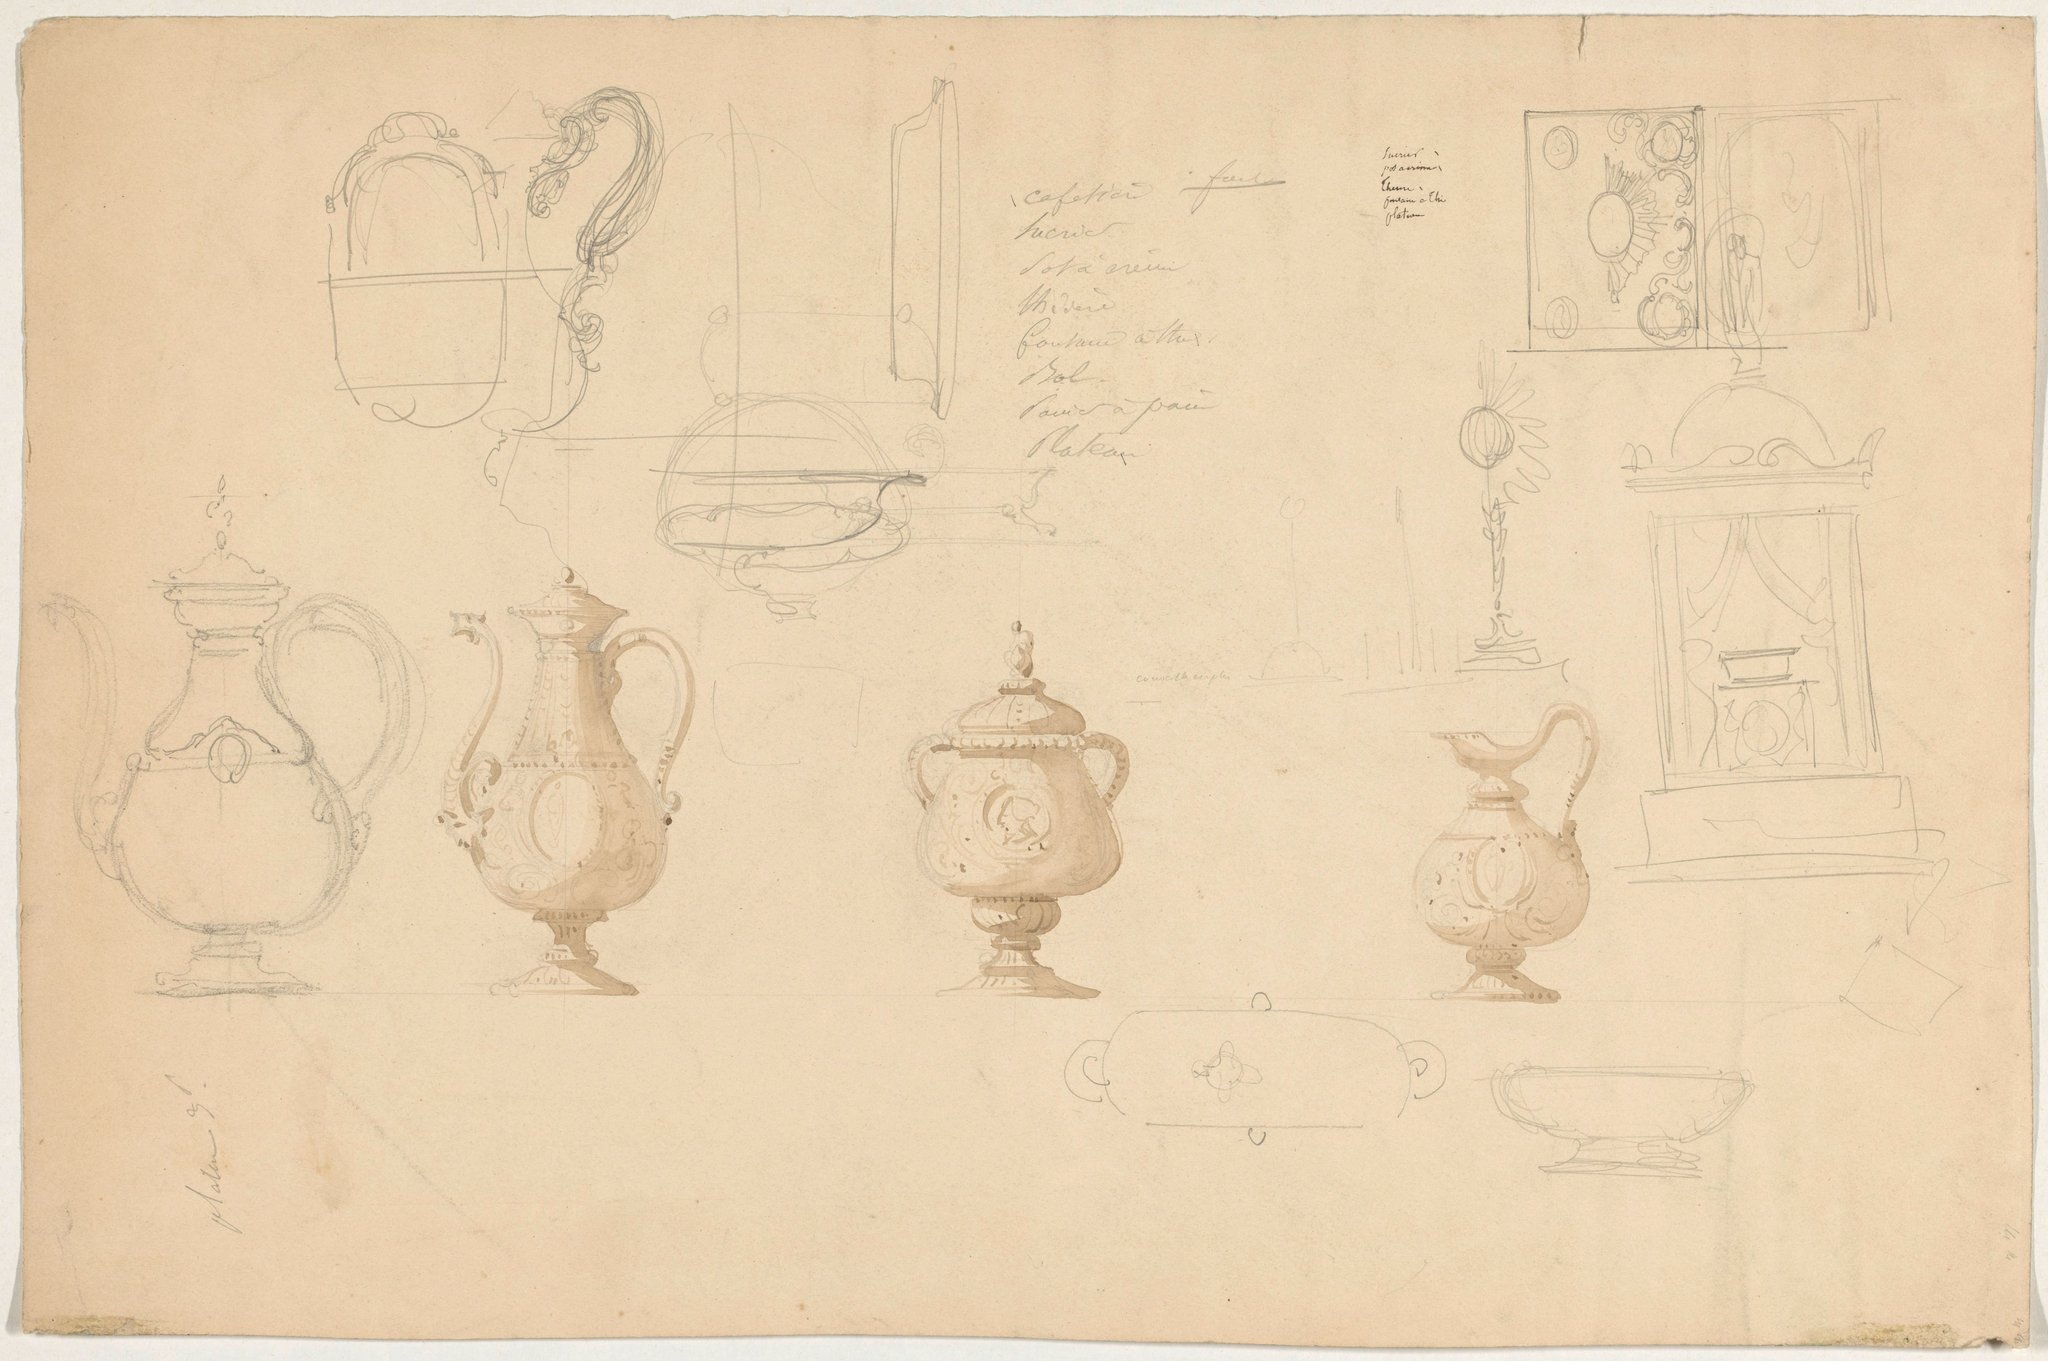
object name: design drawing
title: Koffiepotten en kannen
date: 1830-1850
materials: graphite, paper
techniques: brush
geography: paris